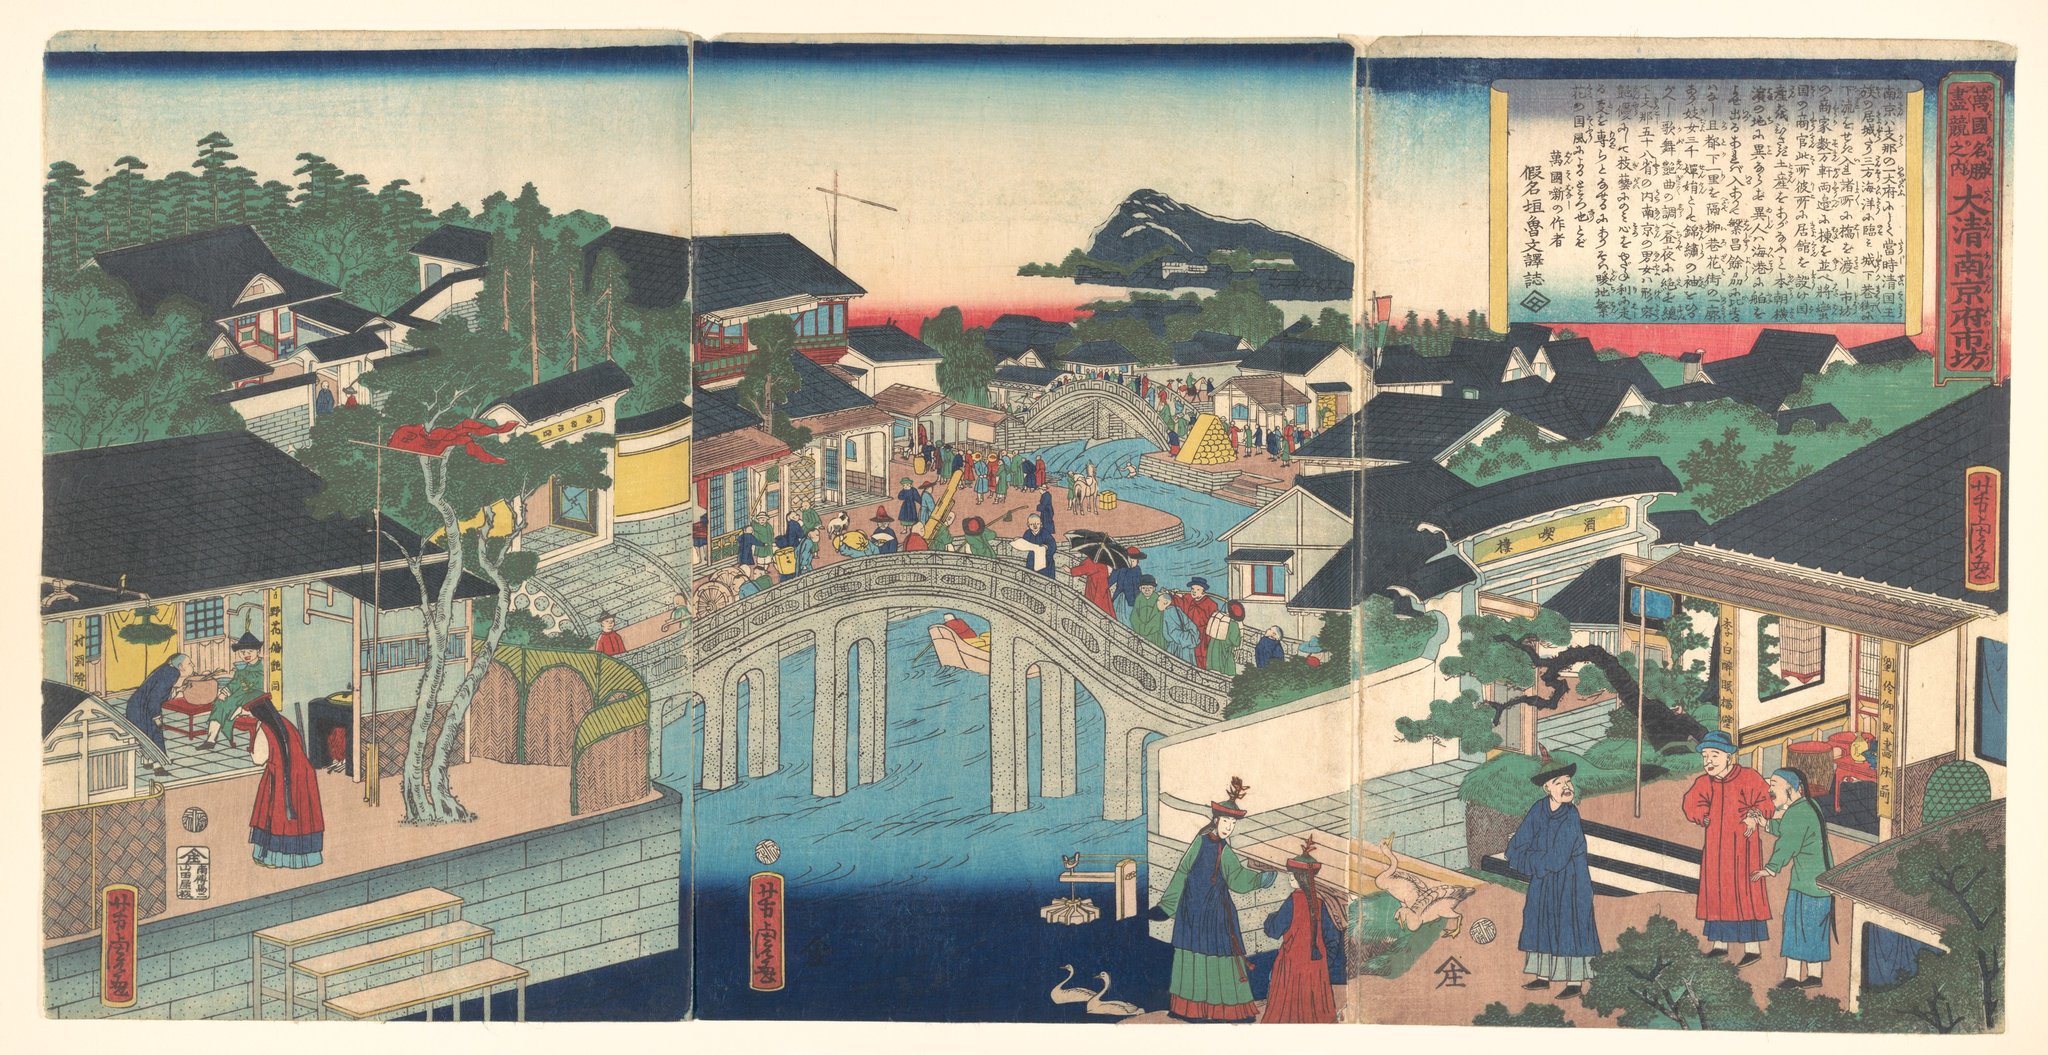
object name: print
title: Nankin in China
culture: japanese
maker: utagawa yoshitora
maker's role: artist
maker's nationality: japanese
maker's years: 1845-1880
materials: ink, paper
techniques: woodblock print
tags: houses,bridges,men,women